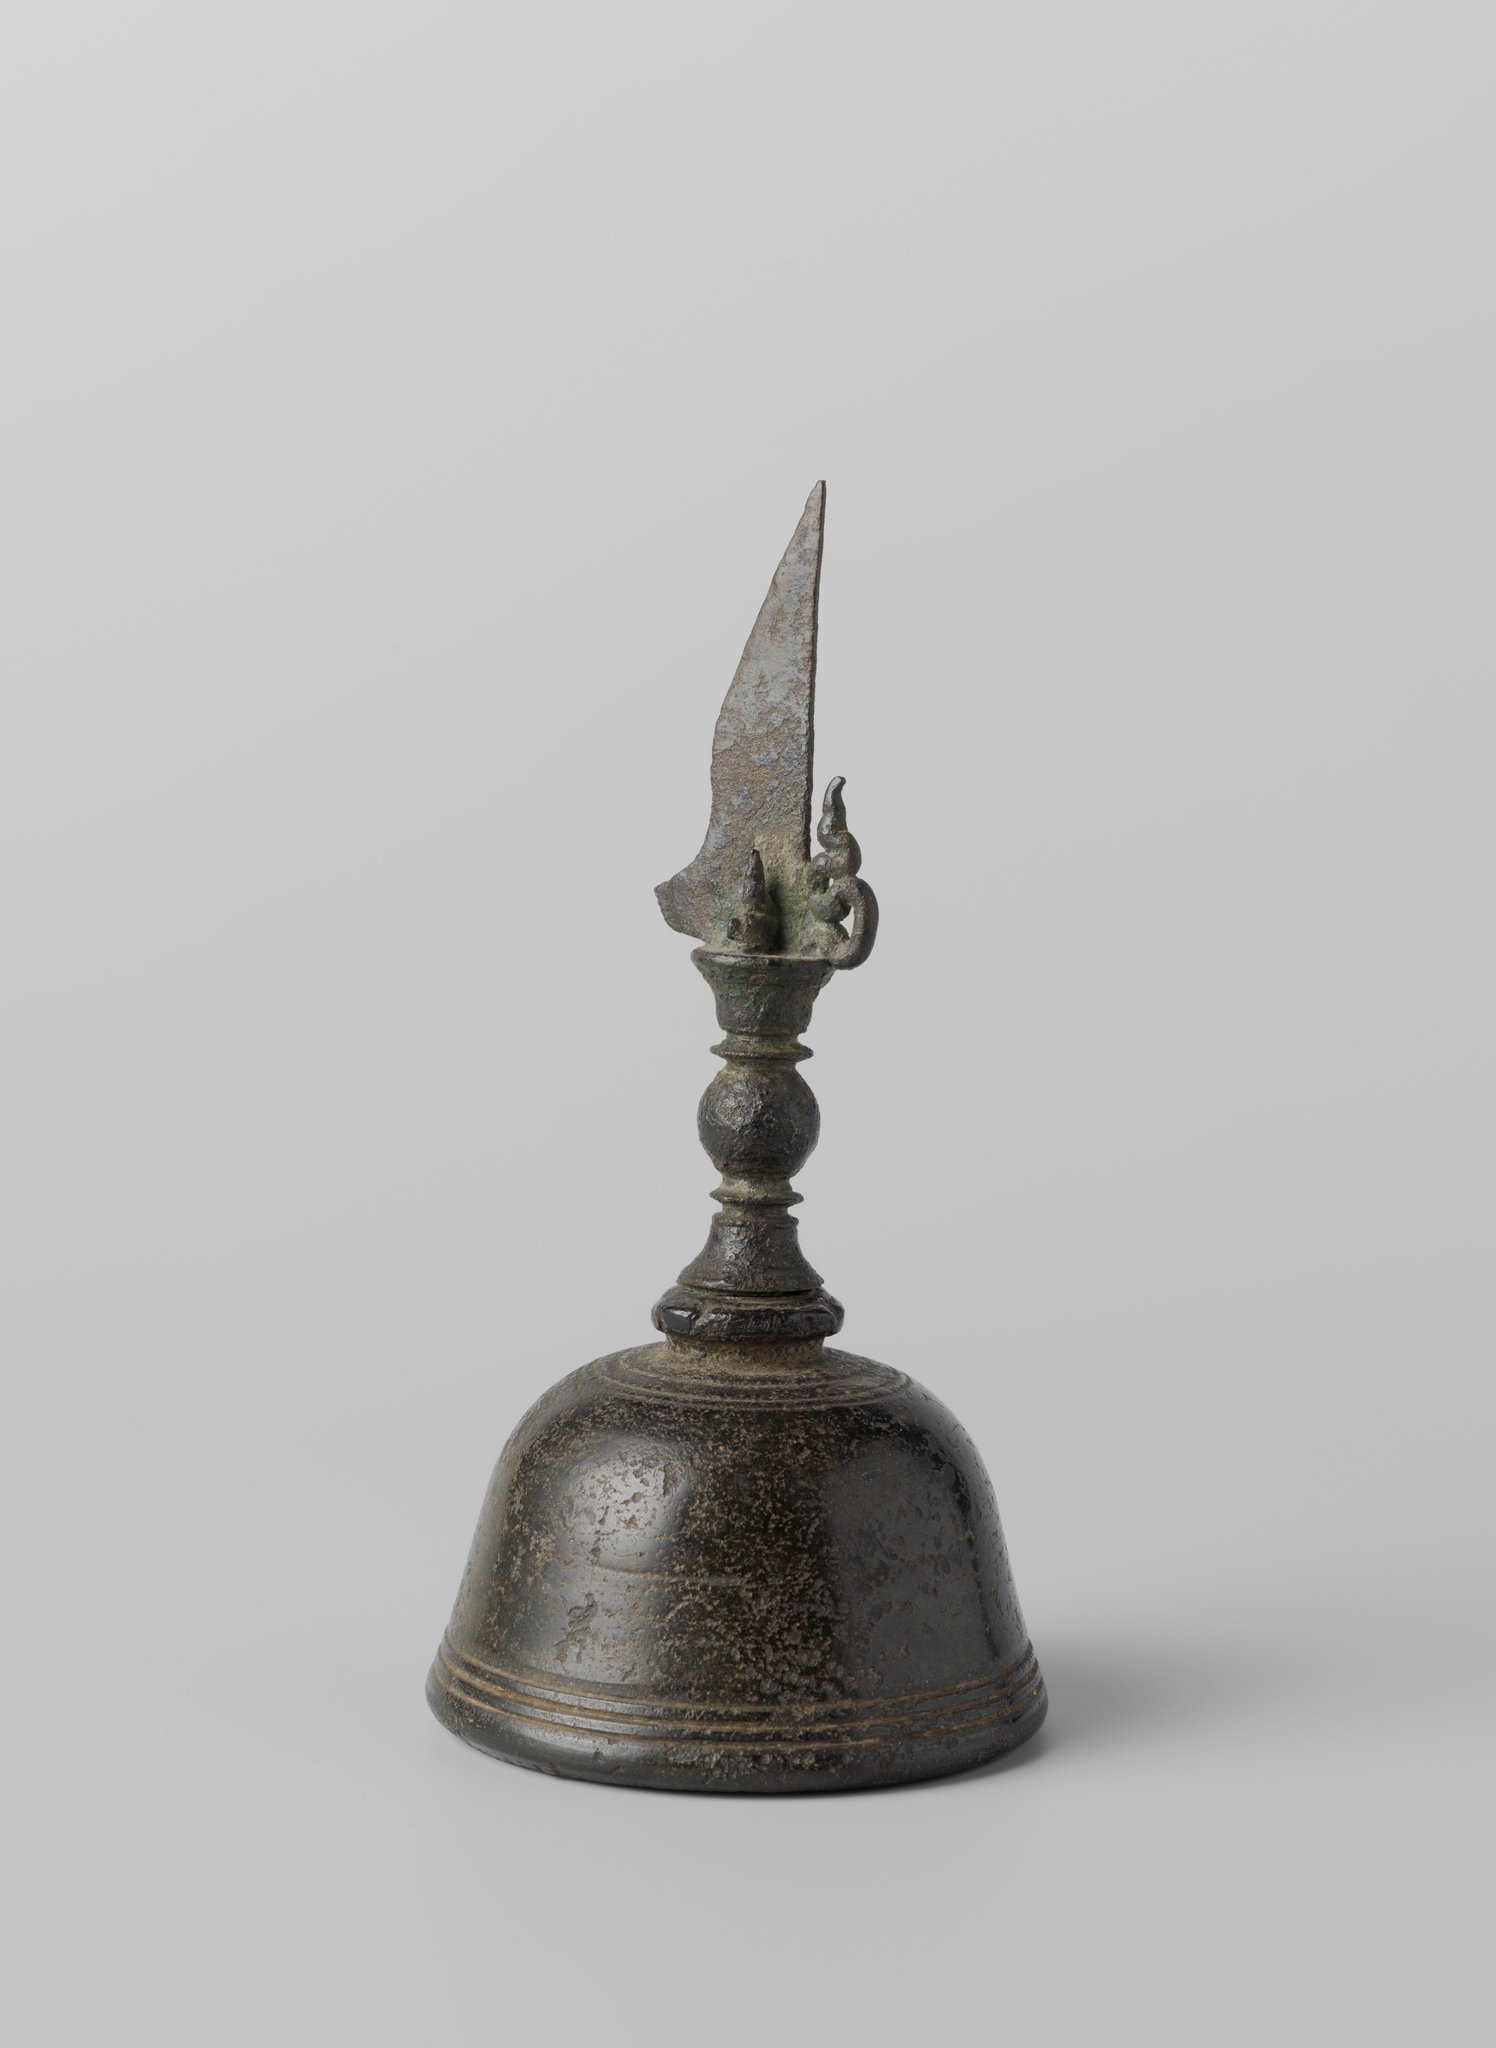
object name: bell idiophone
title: Handbell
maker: Anonymous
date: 1300-1600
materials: bronze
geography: indonesia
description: Priesterschel met topstuk in de vorm van hellebaard.